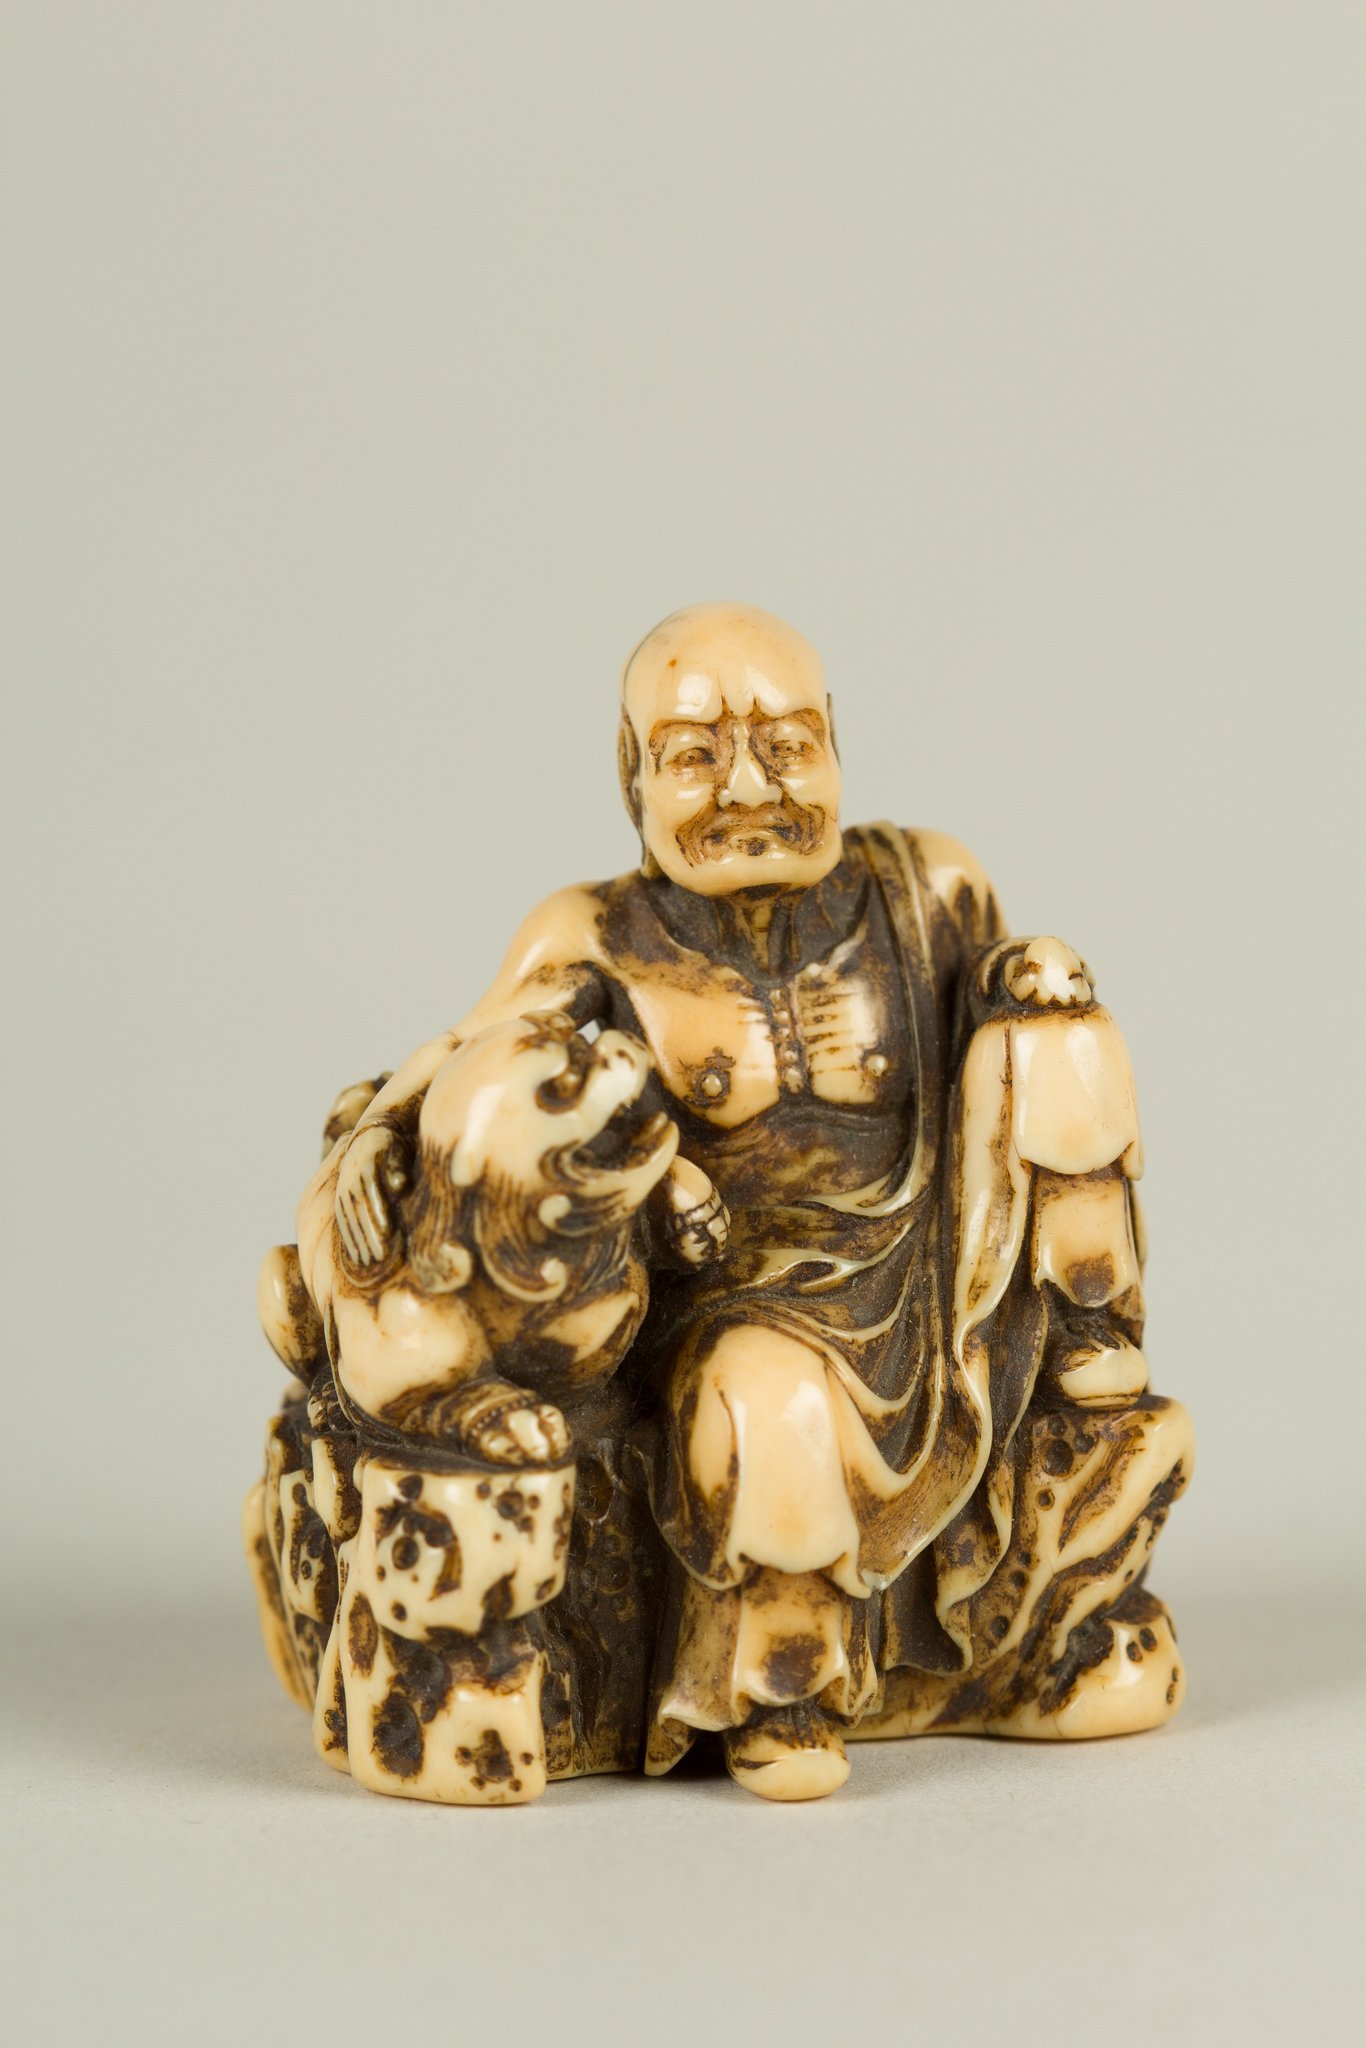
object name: netsuke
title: Netsuke of Man and a Qilin Sitting on a Rock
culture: japanese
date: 1801-1900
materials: ivory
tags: men